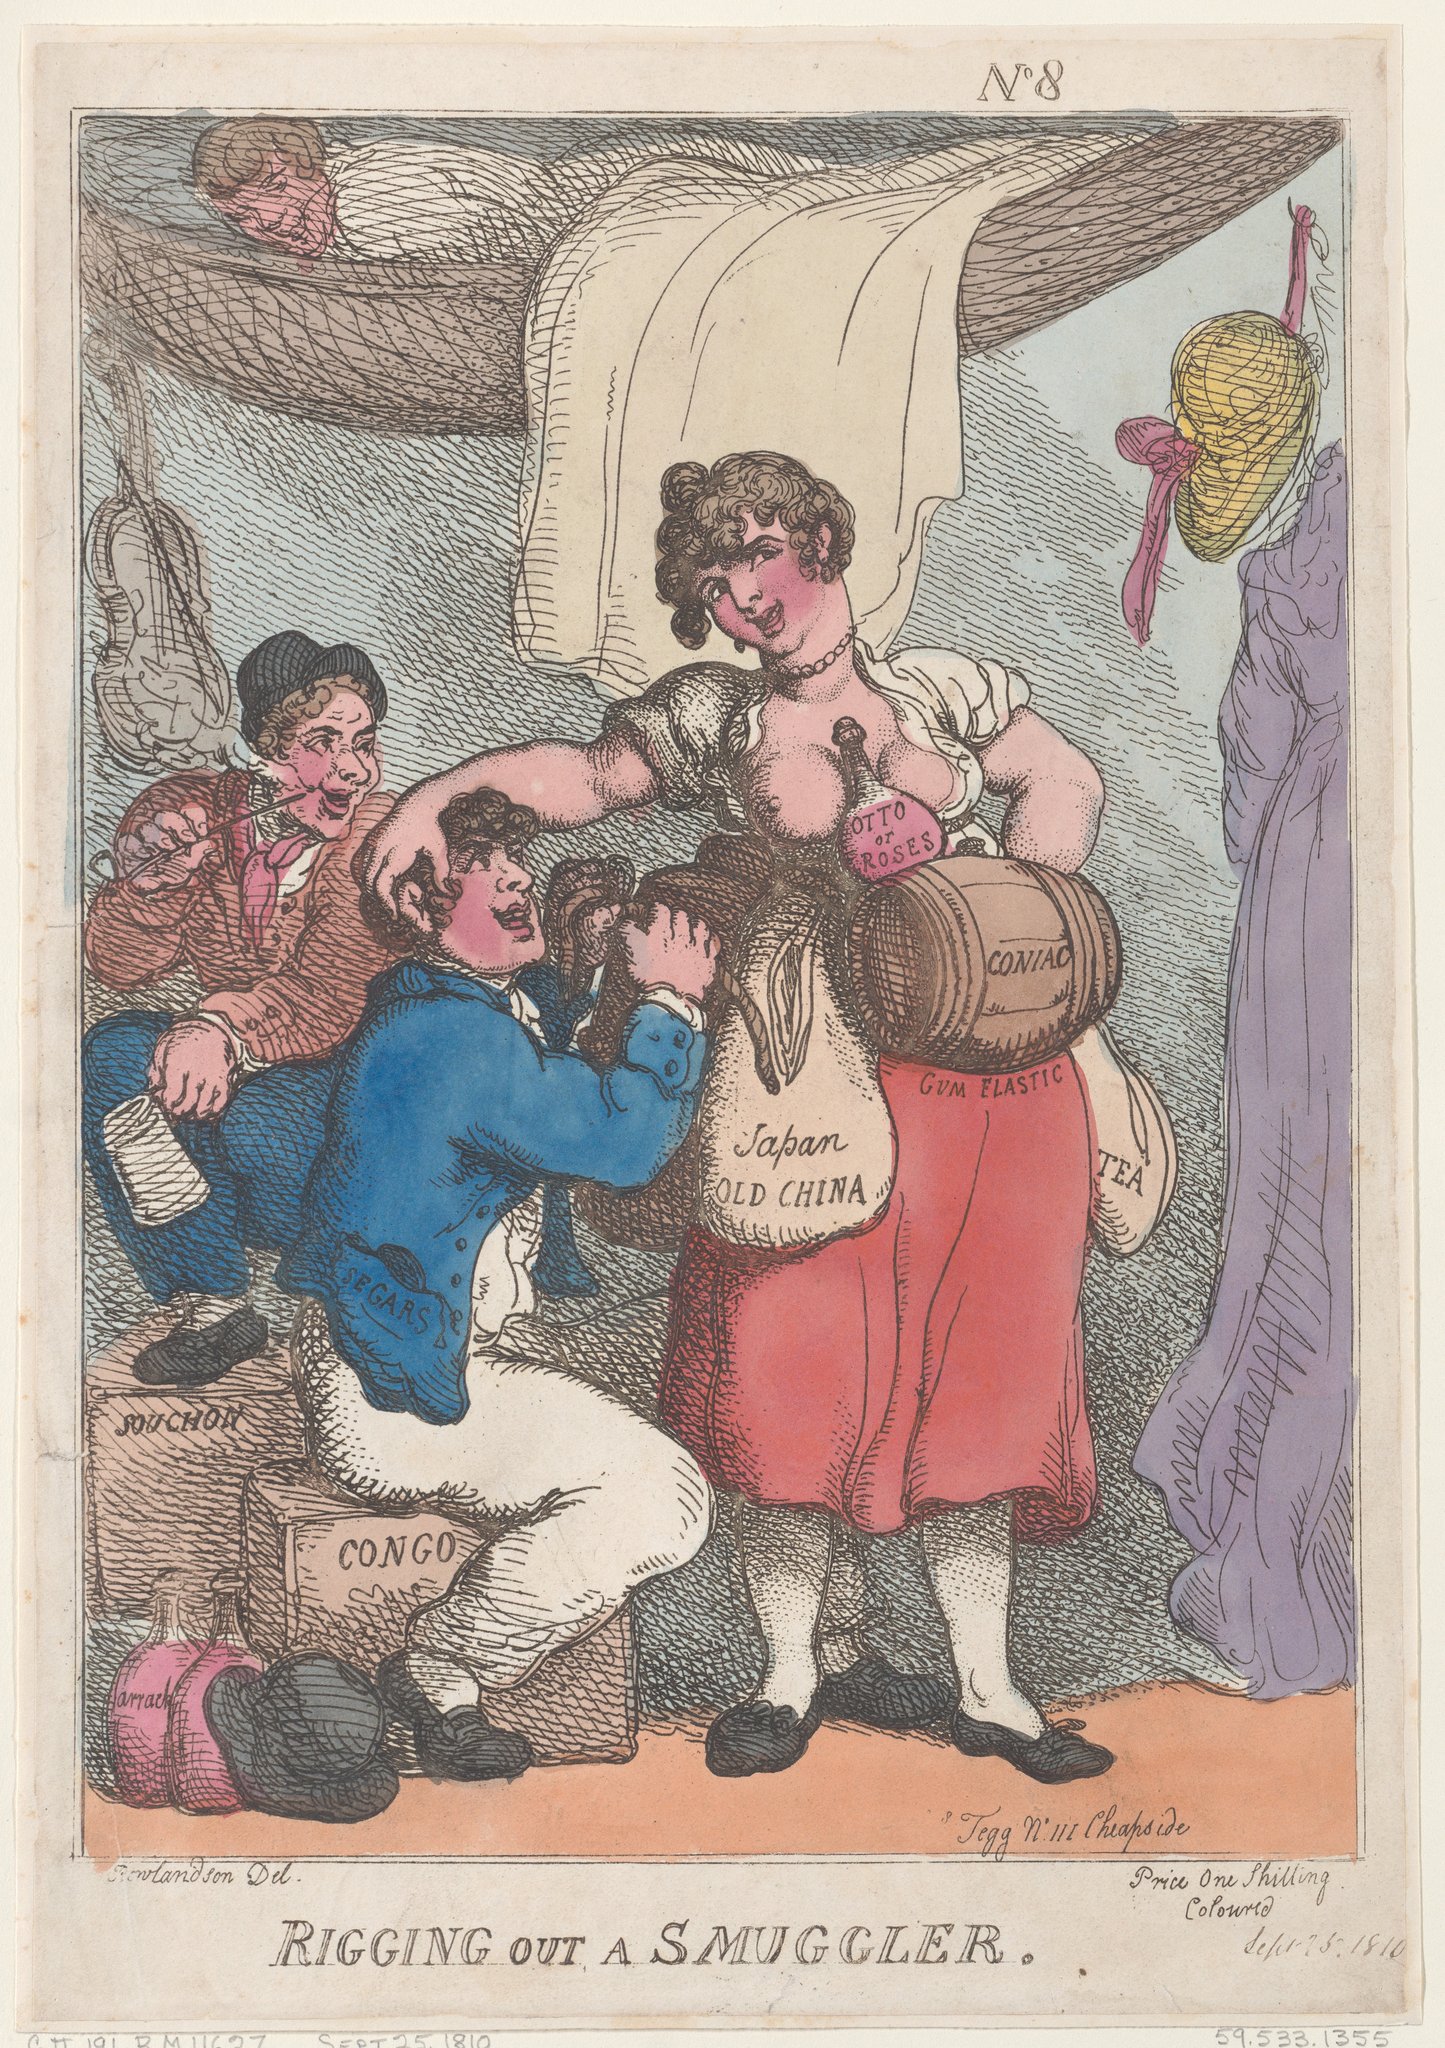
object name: print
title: Rigging Out a Smuggler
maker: thomas rowlandson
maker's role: artist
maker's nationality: british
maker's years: 1757-1827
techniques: etching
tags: satire,men,women,smoking